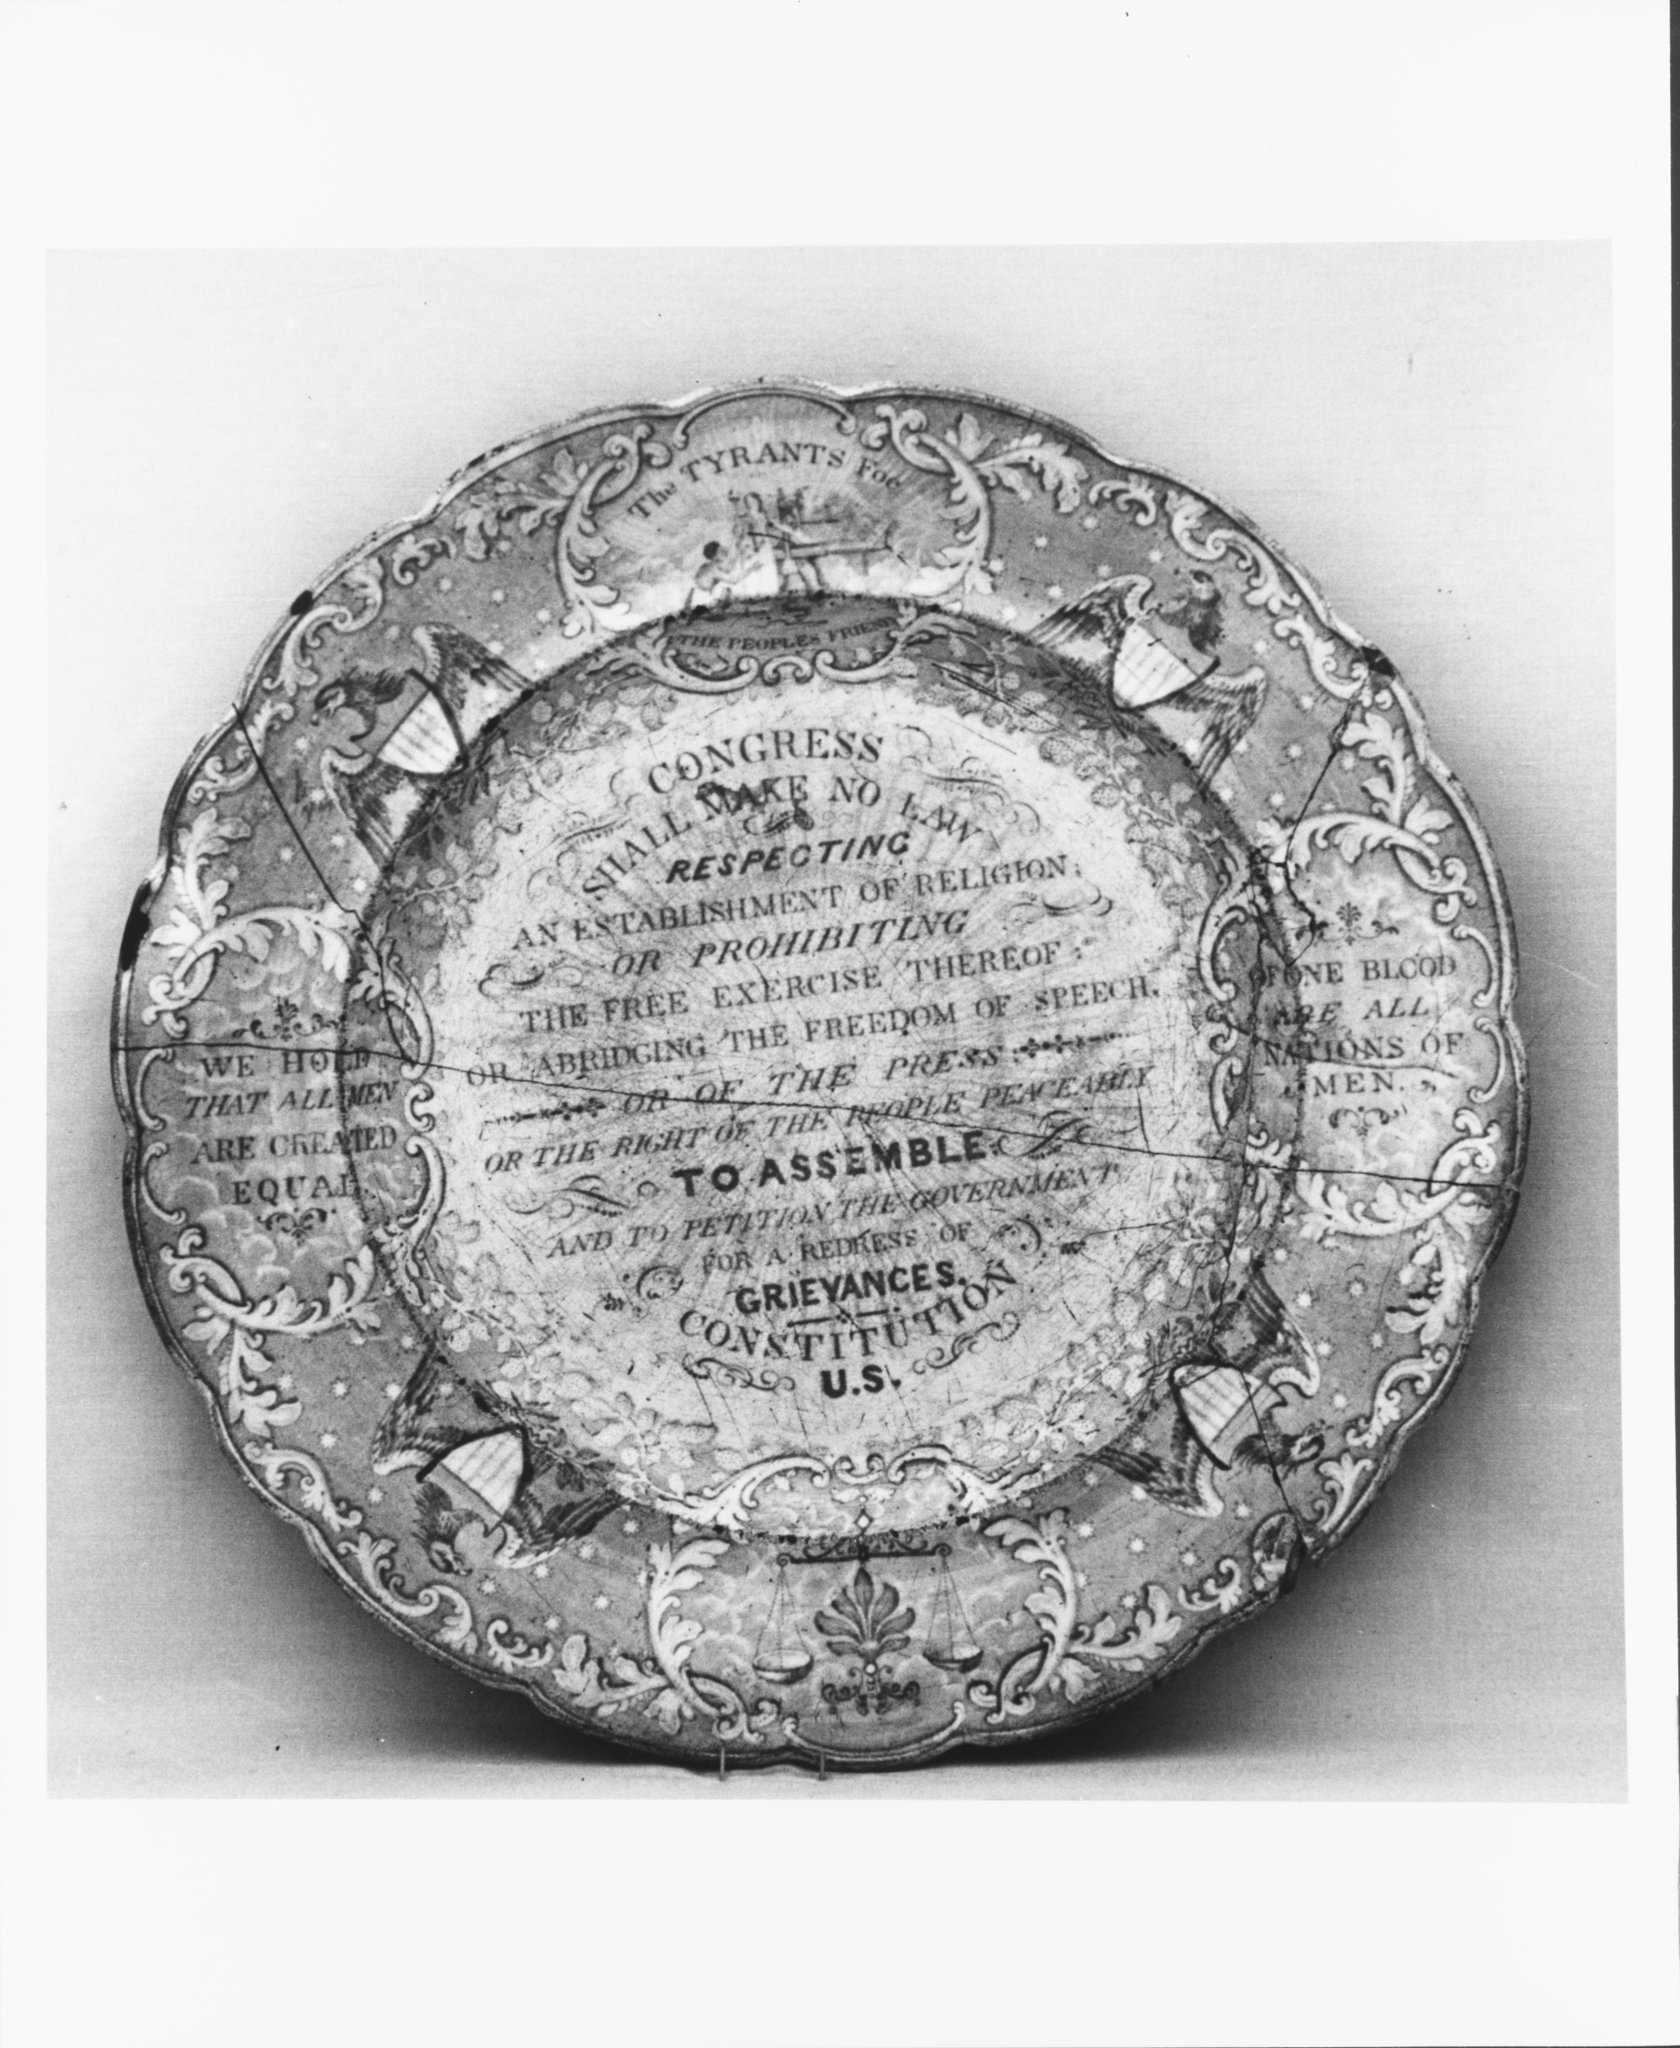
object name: plate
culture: british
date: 1837-1840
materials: earthenware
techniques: transfer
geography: england